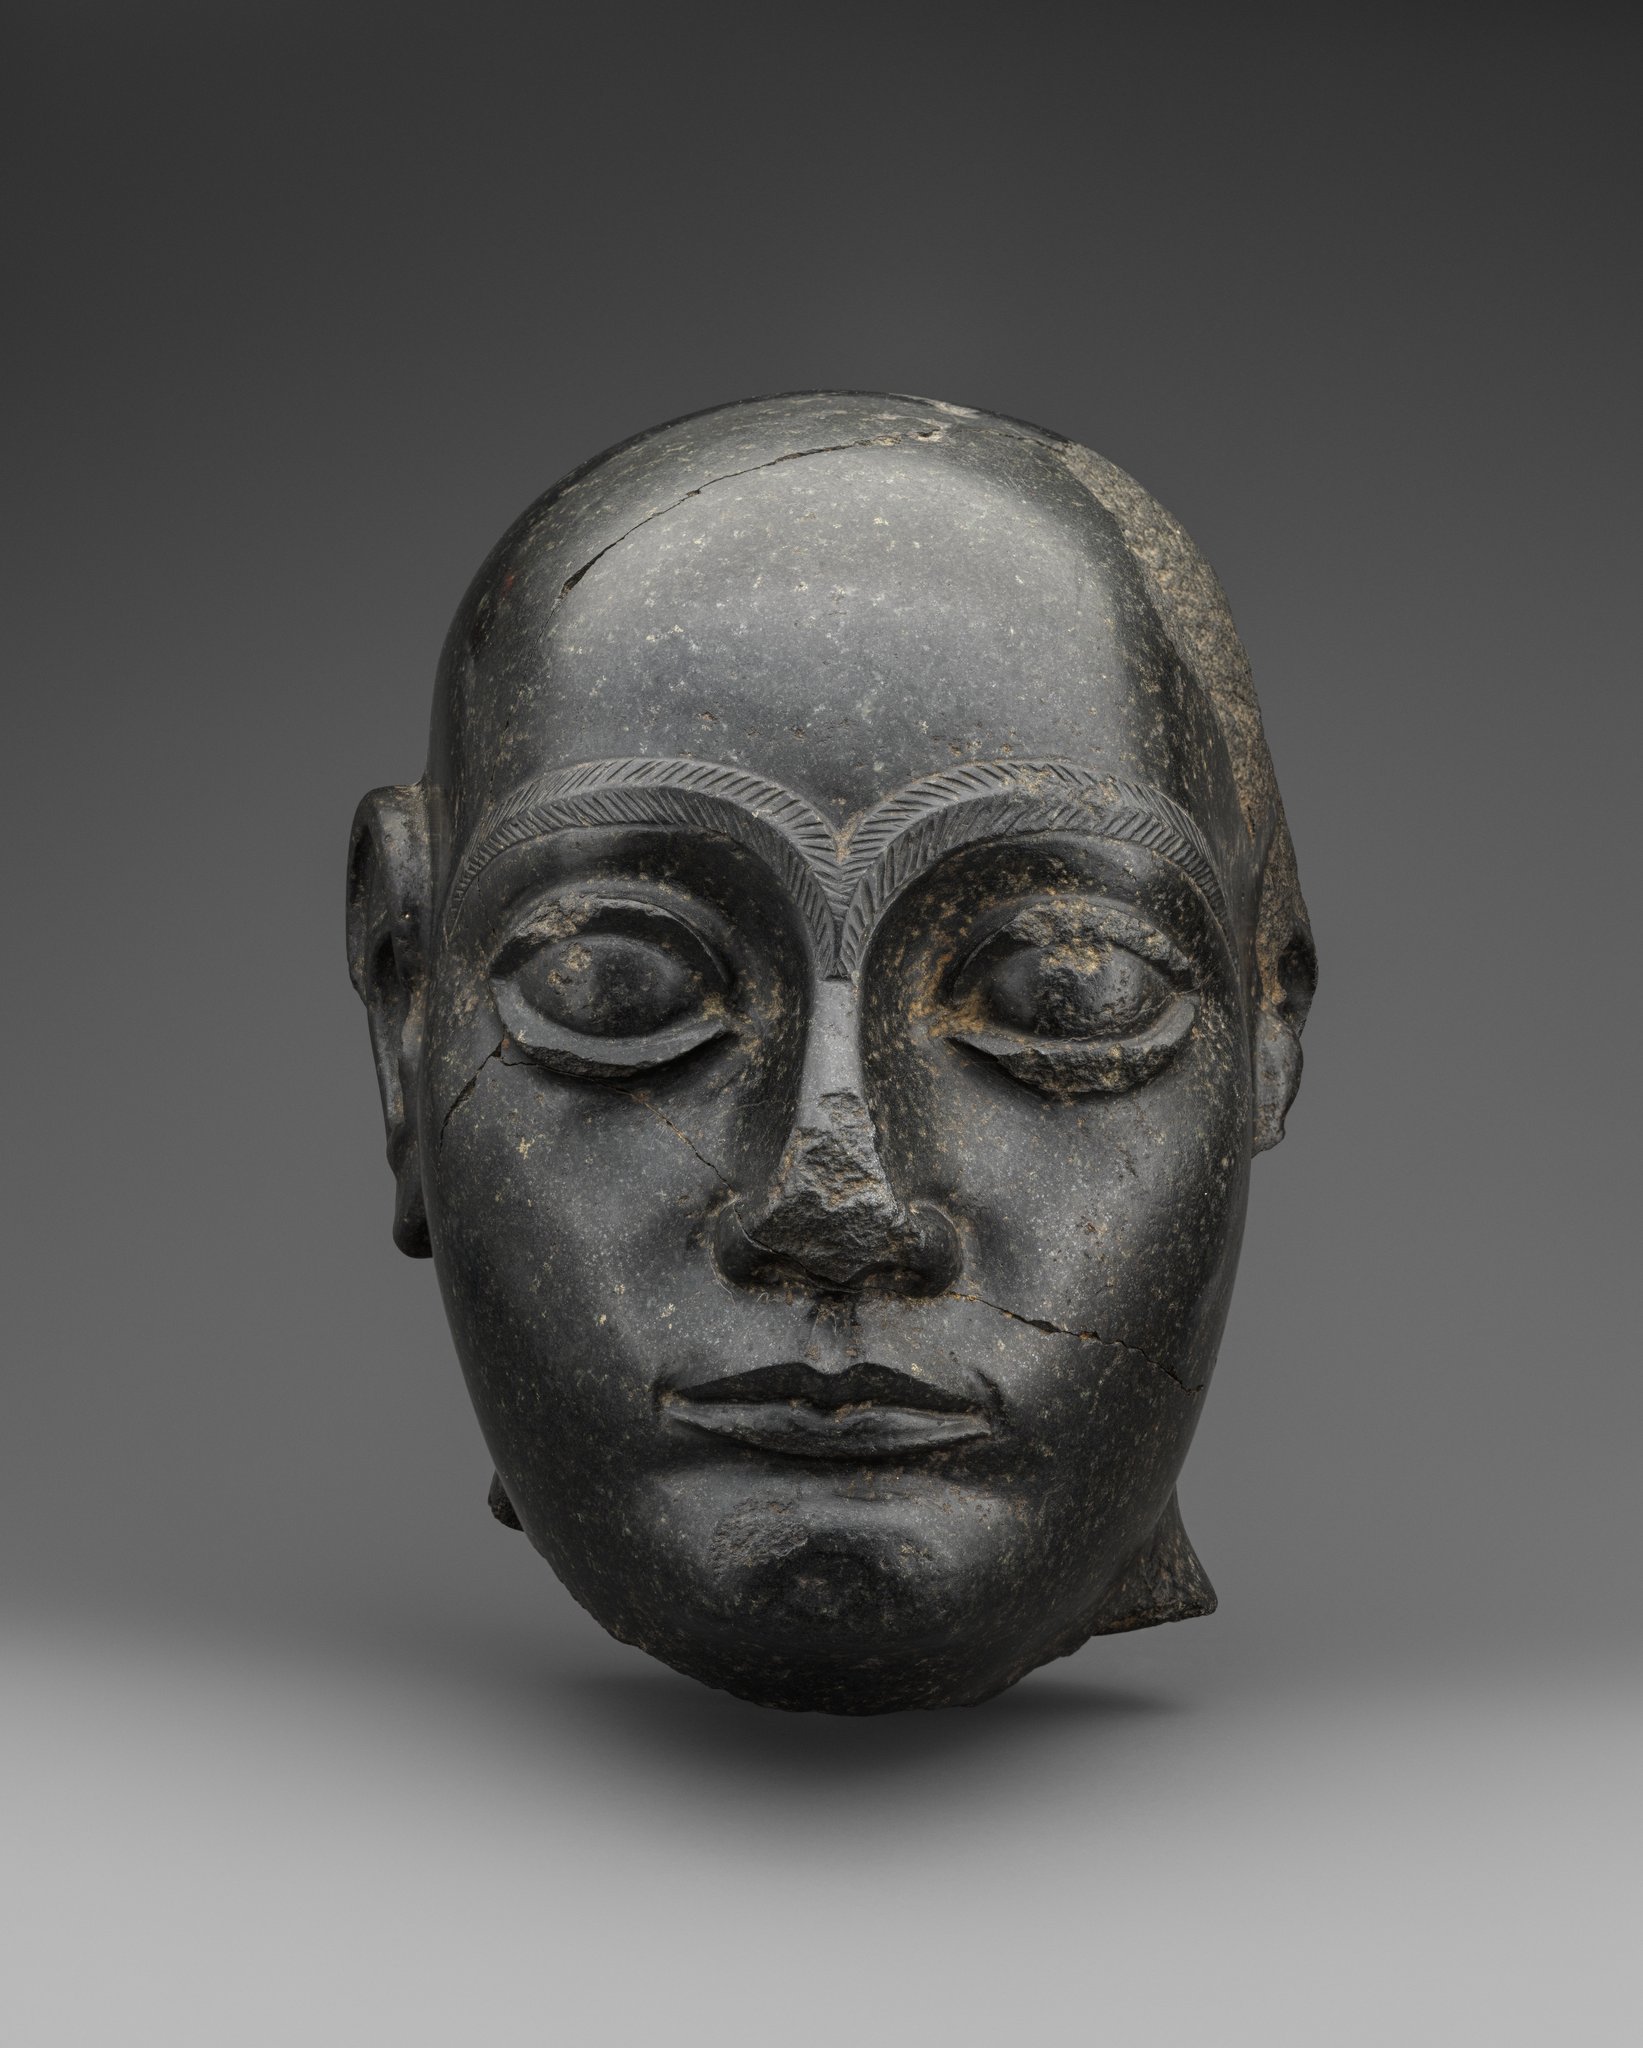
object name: sculpture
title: Head of Gudea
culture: neo-sumerian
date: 2090 BCE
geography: mesopotamia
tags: heads,men